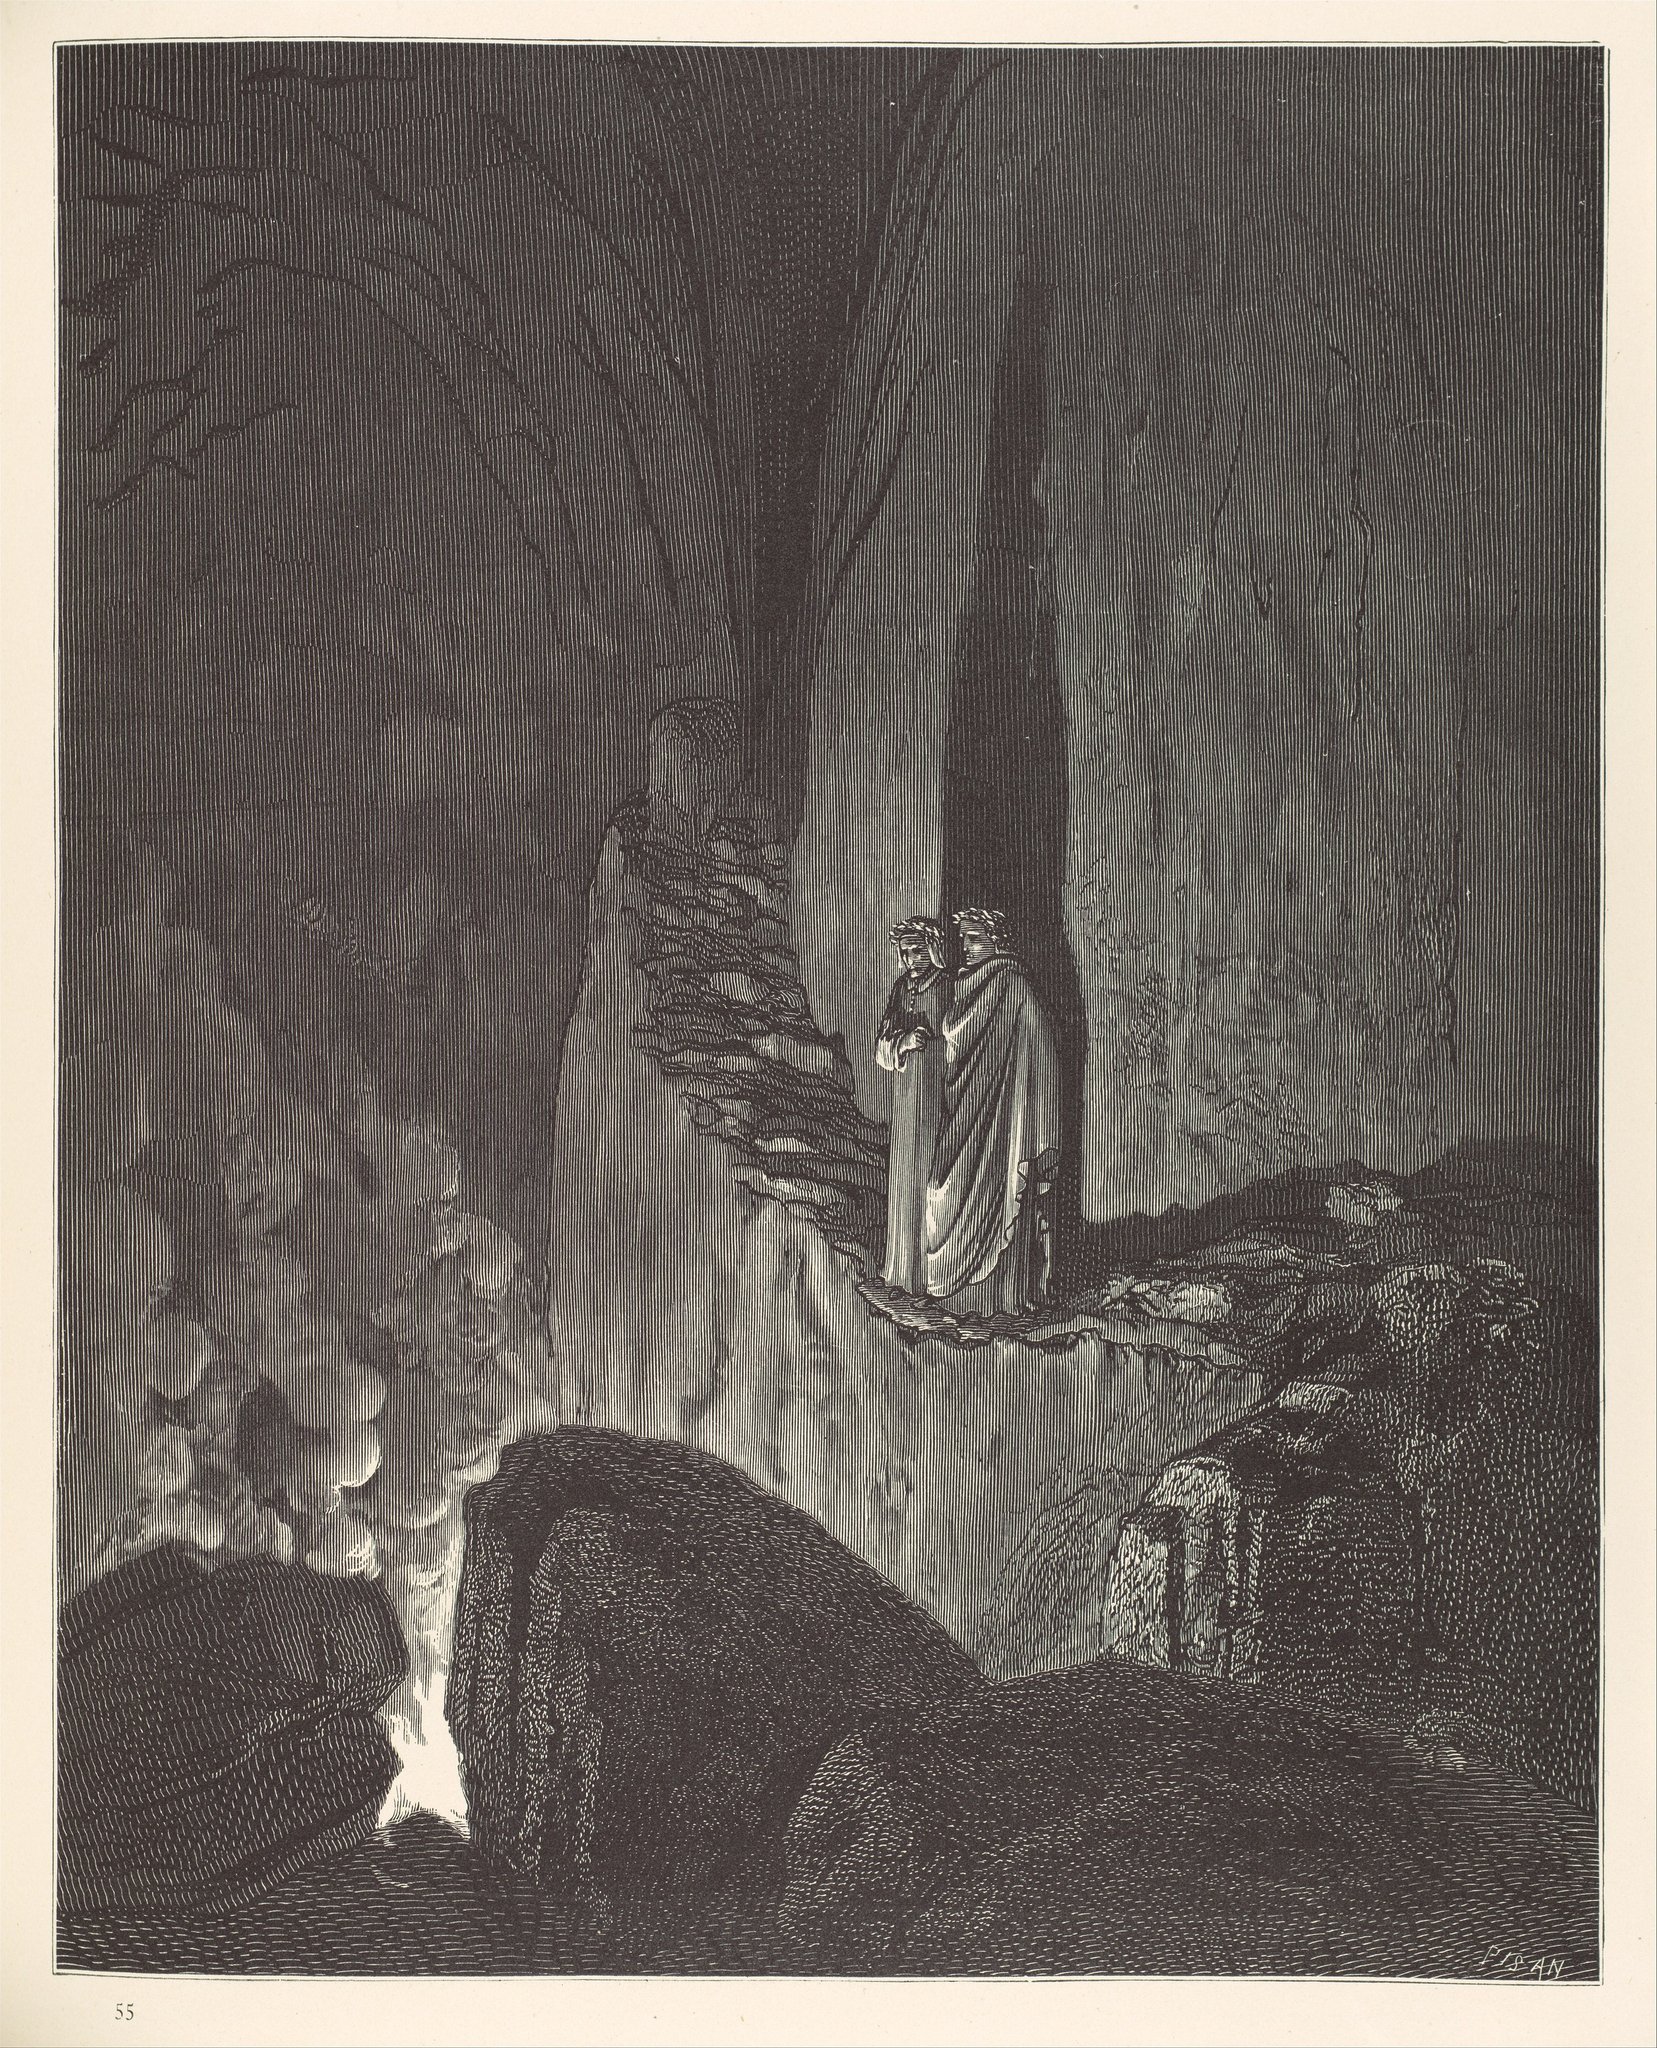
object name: book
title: The Vision of Hell (Inferno)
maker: dante alighieri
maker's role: author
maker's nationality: italian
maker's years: 1265-1321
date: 1866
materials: wood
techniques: engraving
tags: men,hell